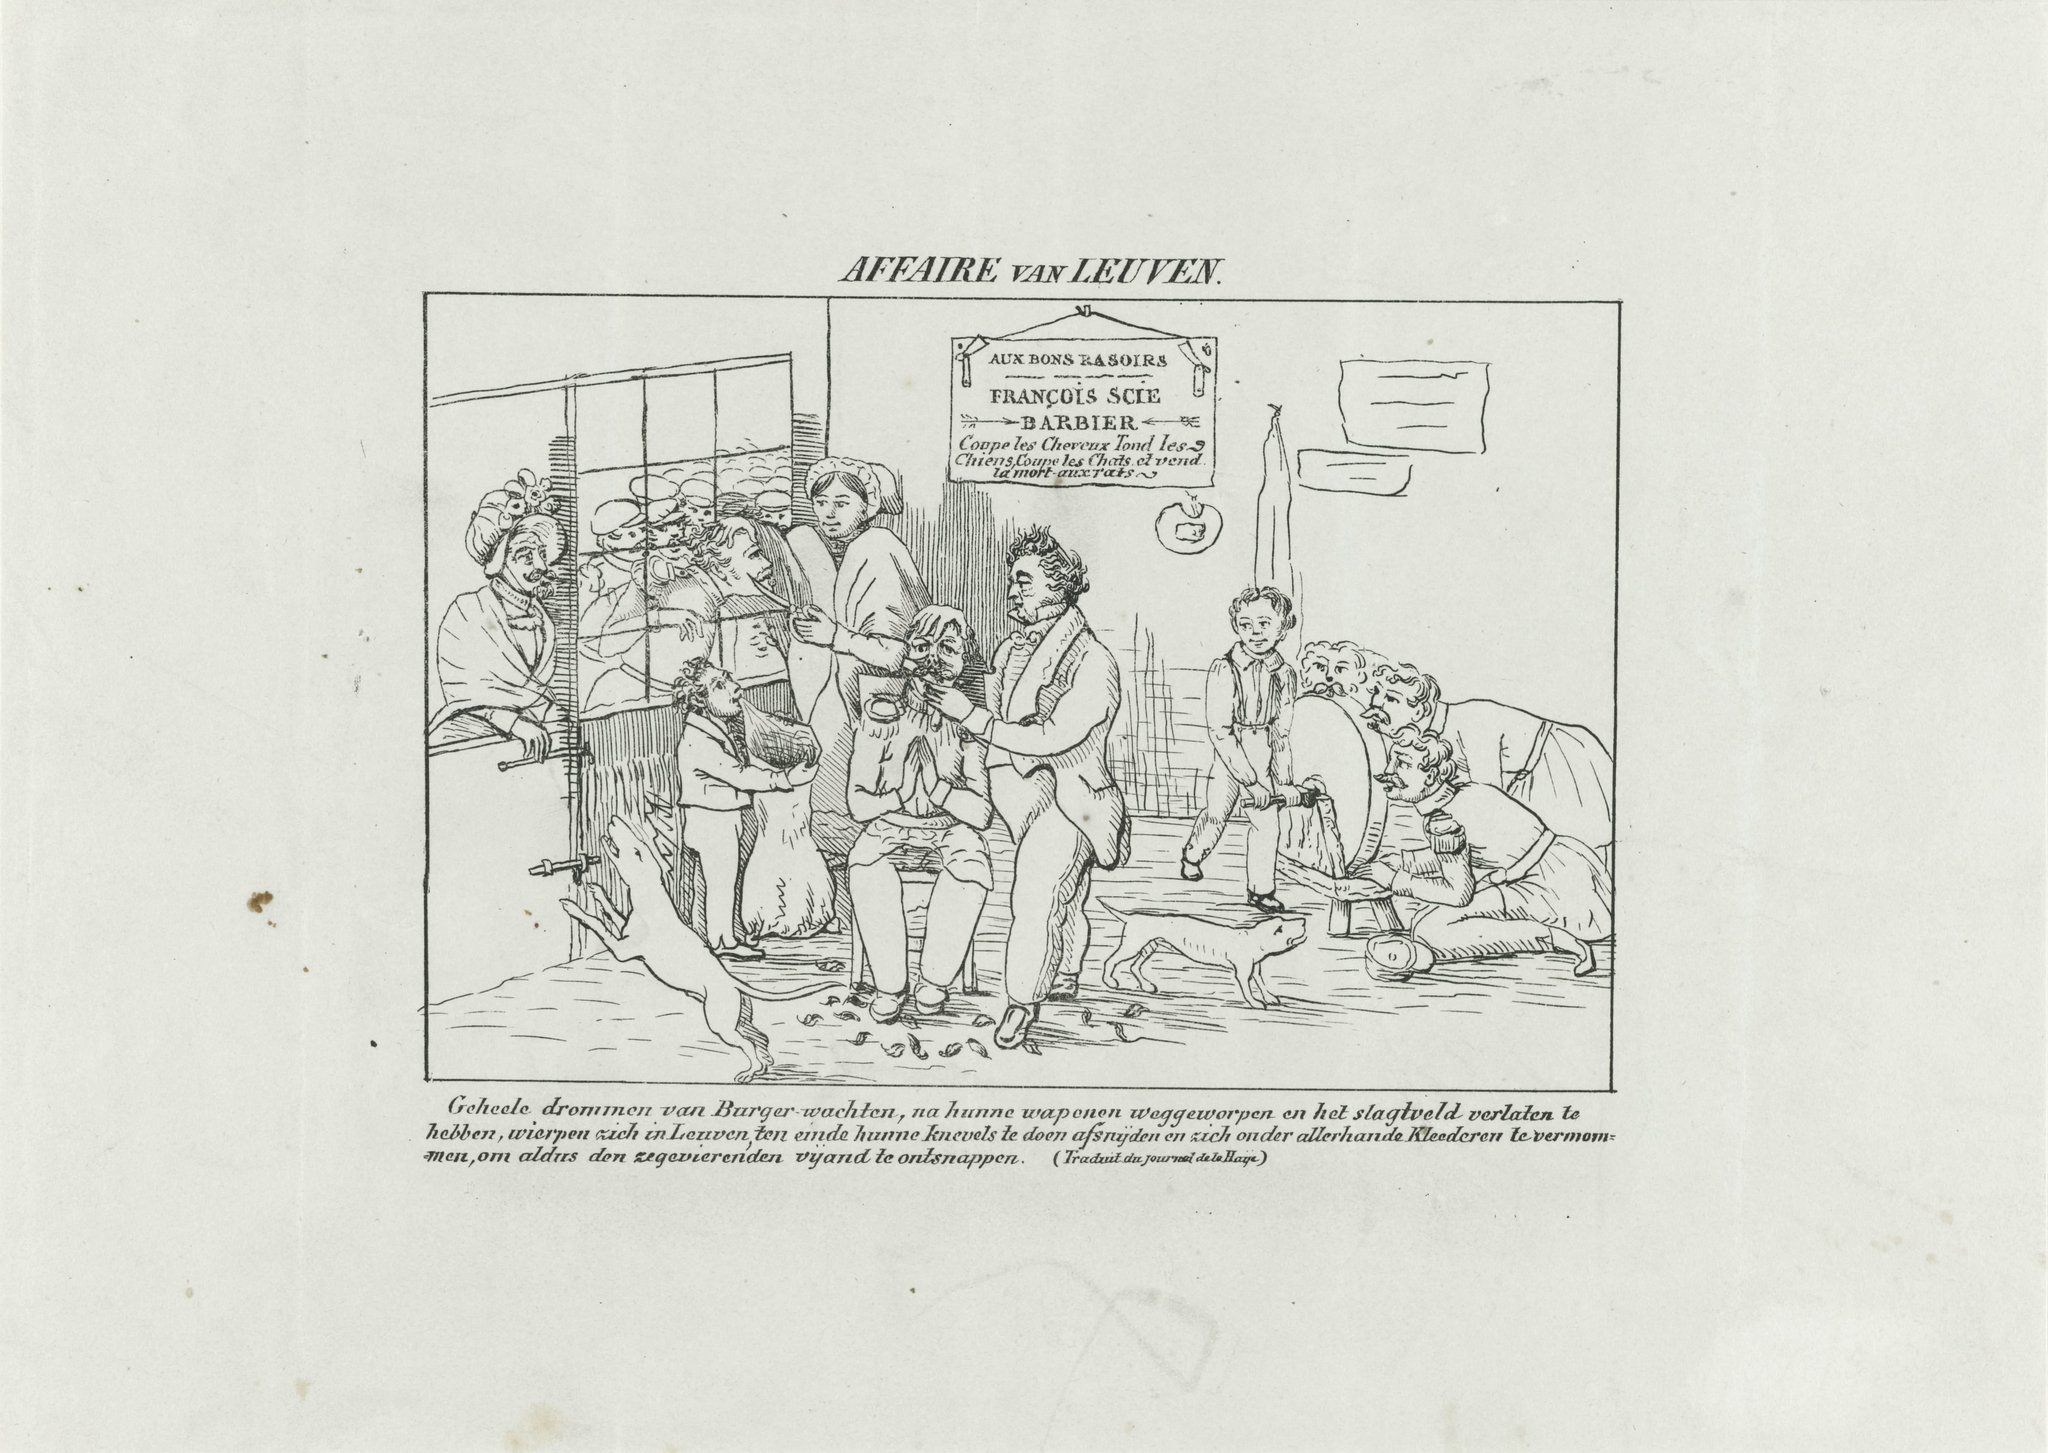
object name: cartoon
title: Spotprent op de gevluchte Belgen tijdens de slag bij Leuven, 1831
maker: Anonymous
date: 1831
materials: paper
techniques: lithograph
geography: netherlands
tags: man dressed as woman, travesty, tools, aids, implements ~ crafts and industries: grindstone, shaving, being shaved, putting the enemy to flight, louvain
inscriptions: collector's mark: Lugt 2228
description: Spotprent op het vluchten van de Belgen tijdens de slag bij Leuven op 12 augustus 1831. In een kapperswinkel van de barbier 'François Scie' worden de Belgische militairen geschoren van hun baarden en snorren. Rechts liggen drie Belgen met hun gezicht aan de slijpsteen, links een militaire als vrouw verkleed. Met drieregelig onderschrift.